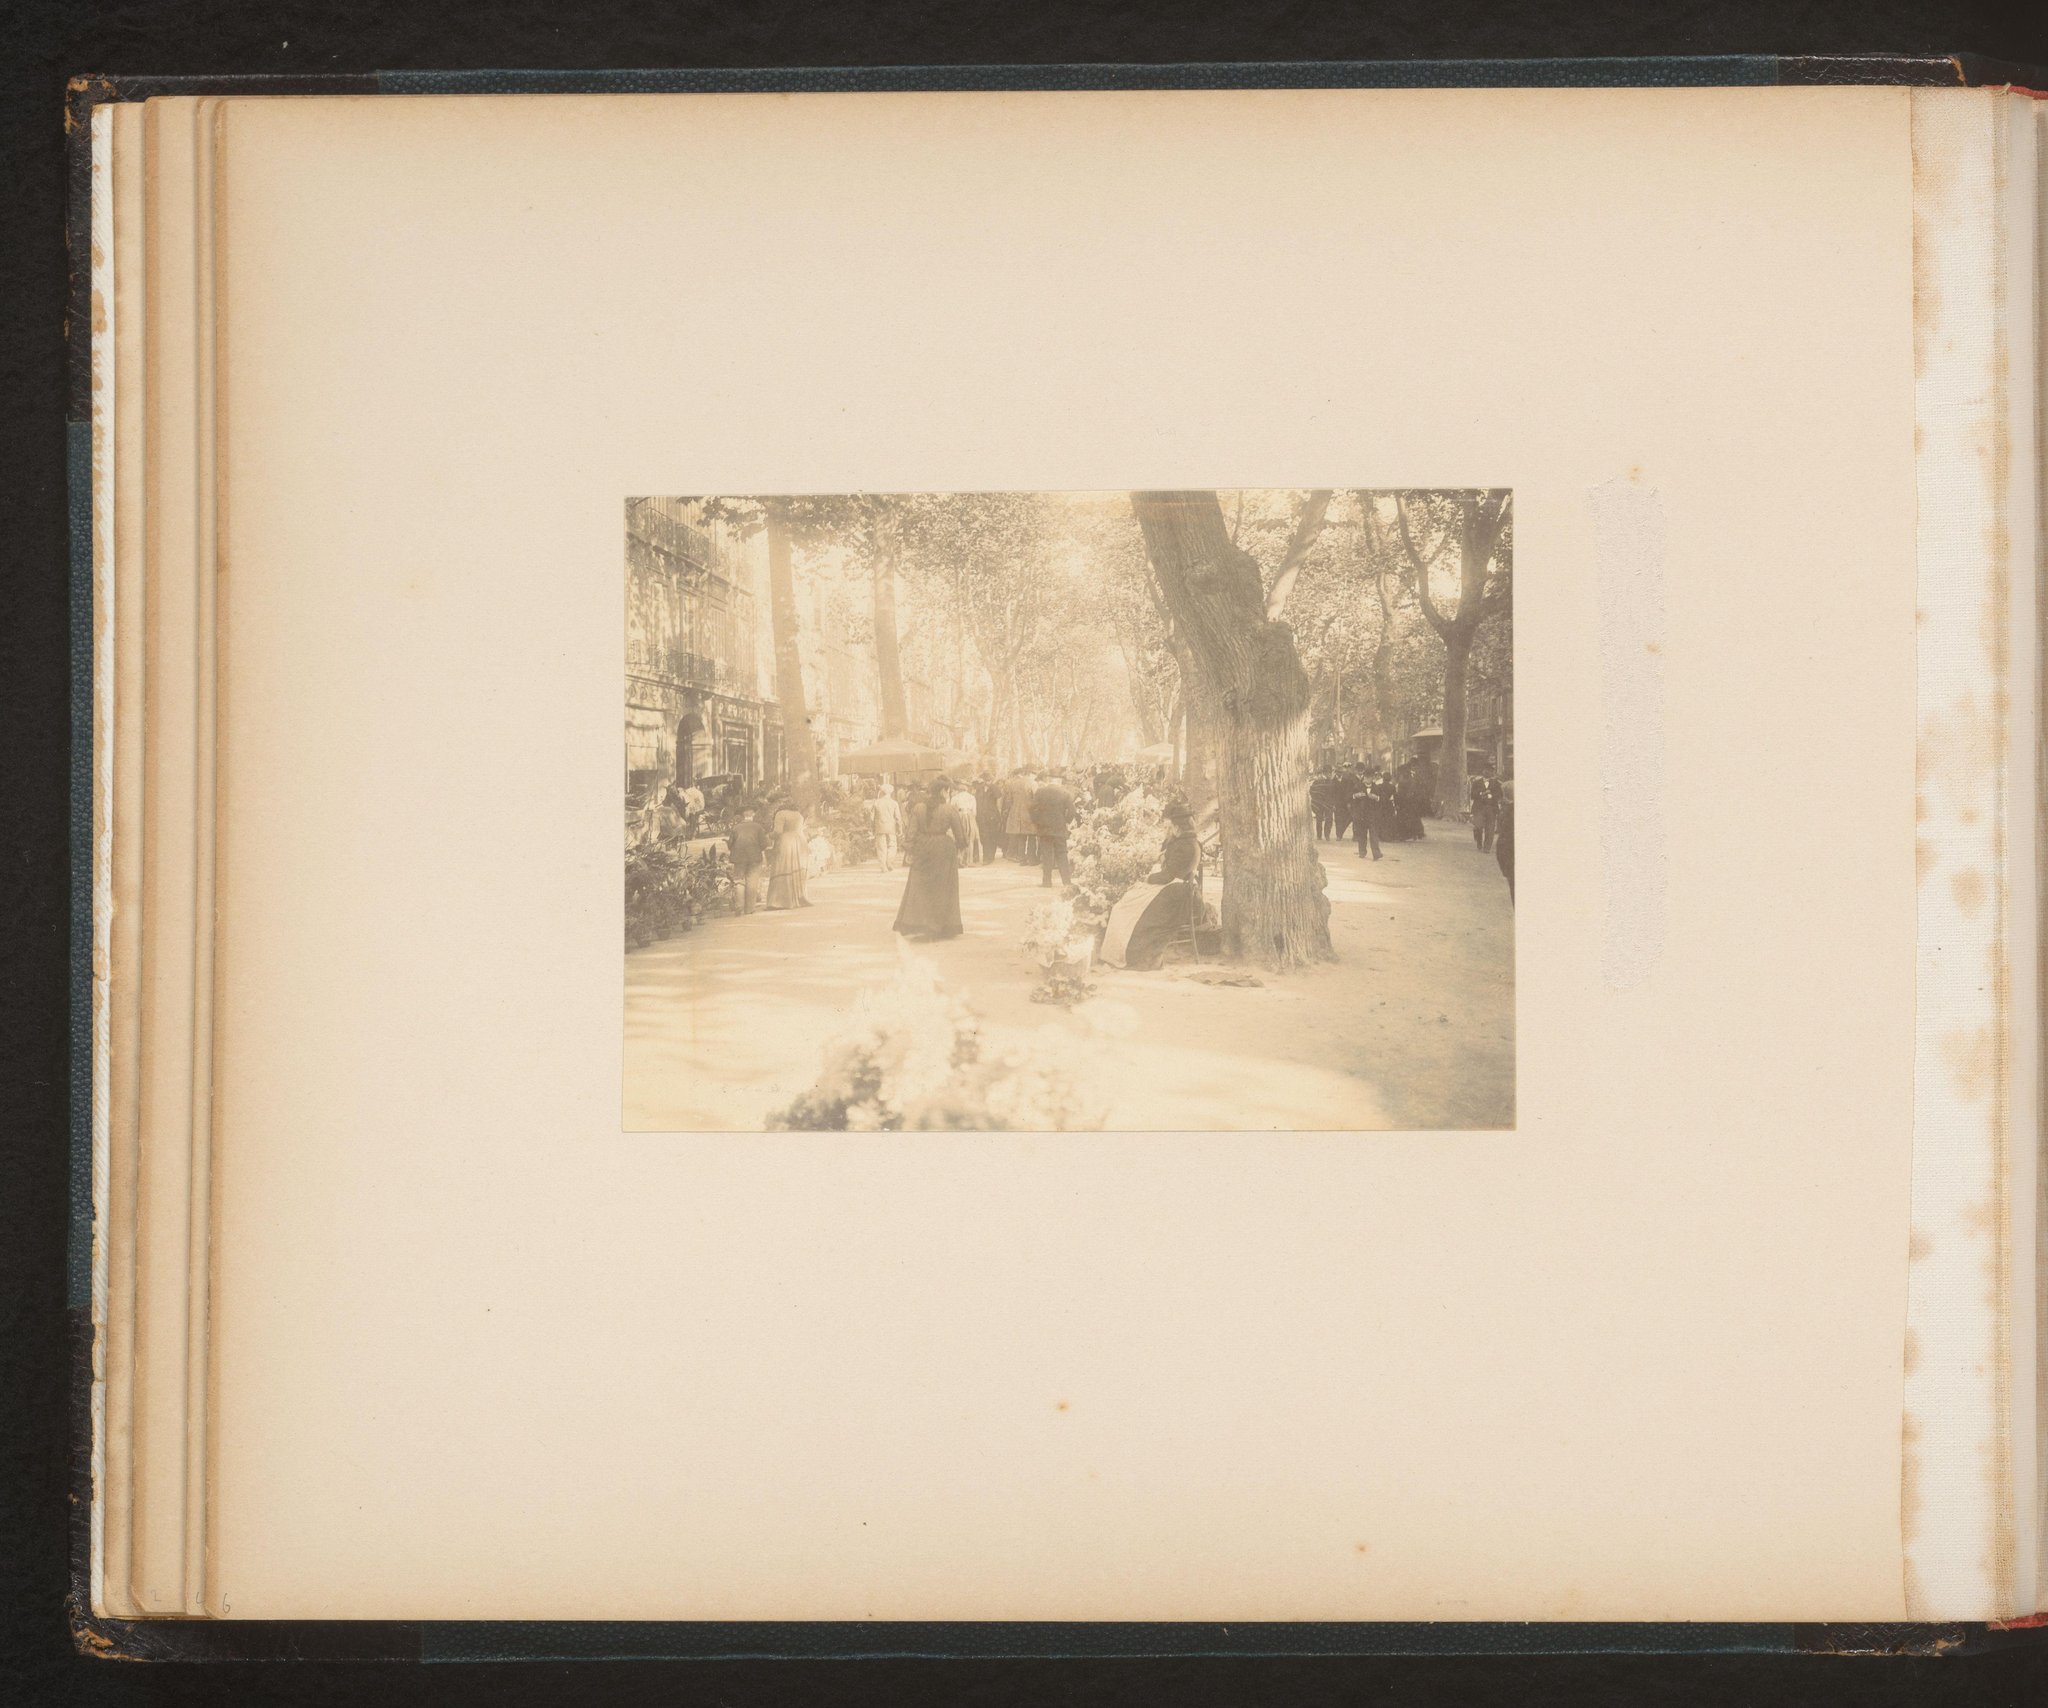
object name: album leaf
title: Straatgezicht te Frankrijk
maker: Anonymous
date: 1880-1920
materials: cardboard, photographic support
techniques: gelatin silver print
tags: trees, historical persons, street, france